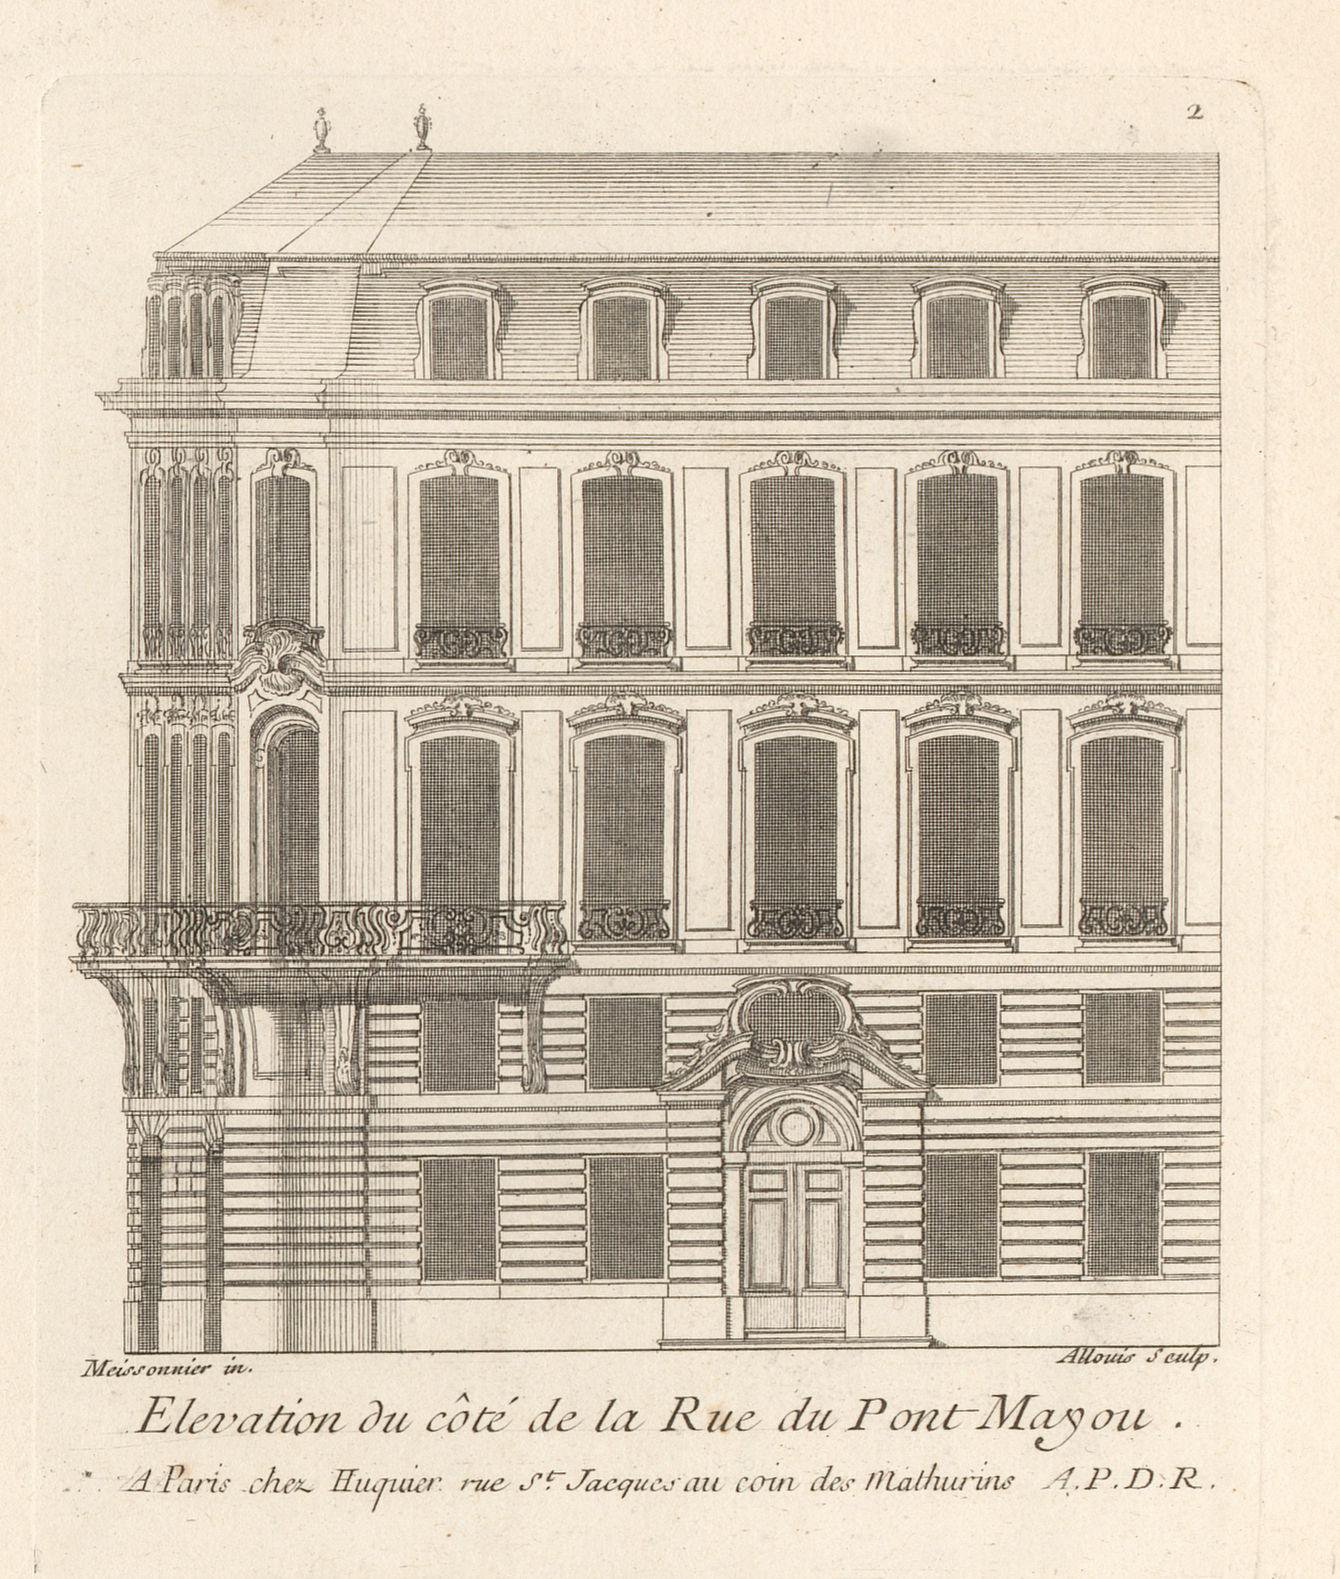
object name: album leaf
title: Oeuvre de Juste Aurele Meissonnier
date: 1738-1749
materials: paper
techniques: etching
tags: exterior ~ representation of a building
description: Prent uit een serie van elf etsen met architectuurontwerpen en plattegronden van dit huis. Deze prent maakt deel uit van een album.